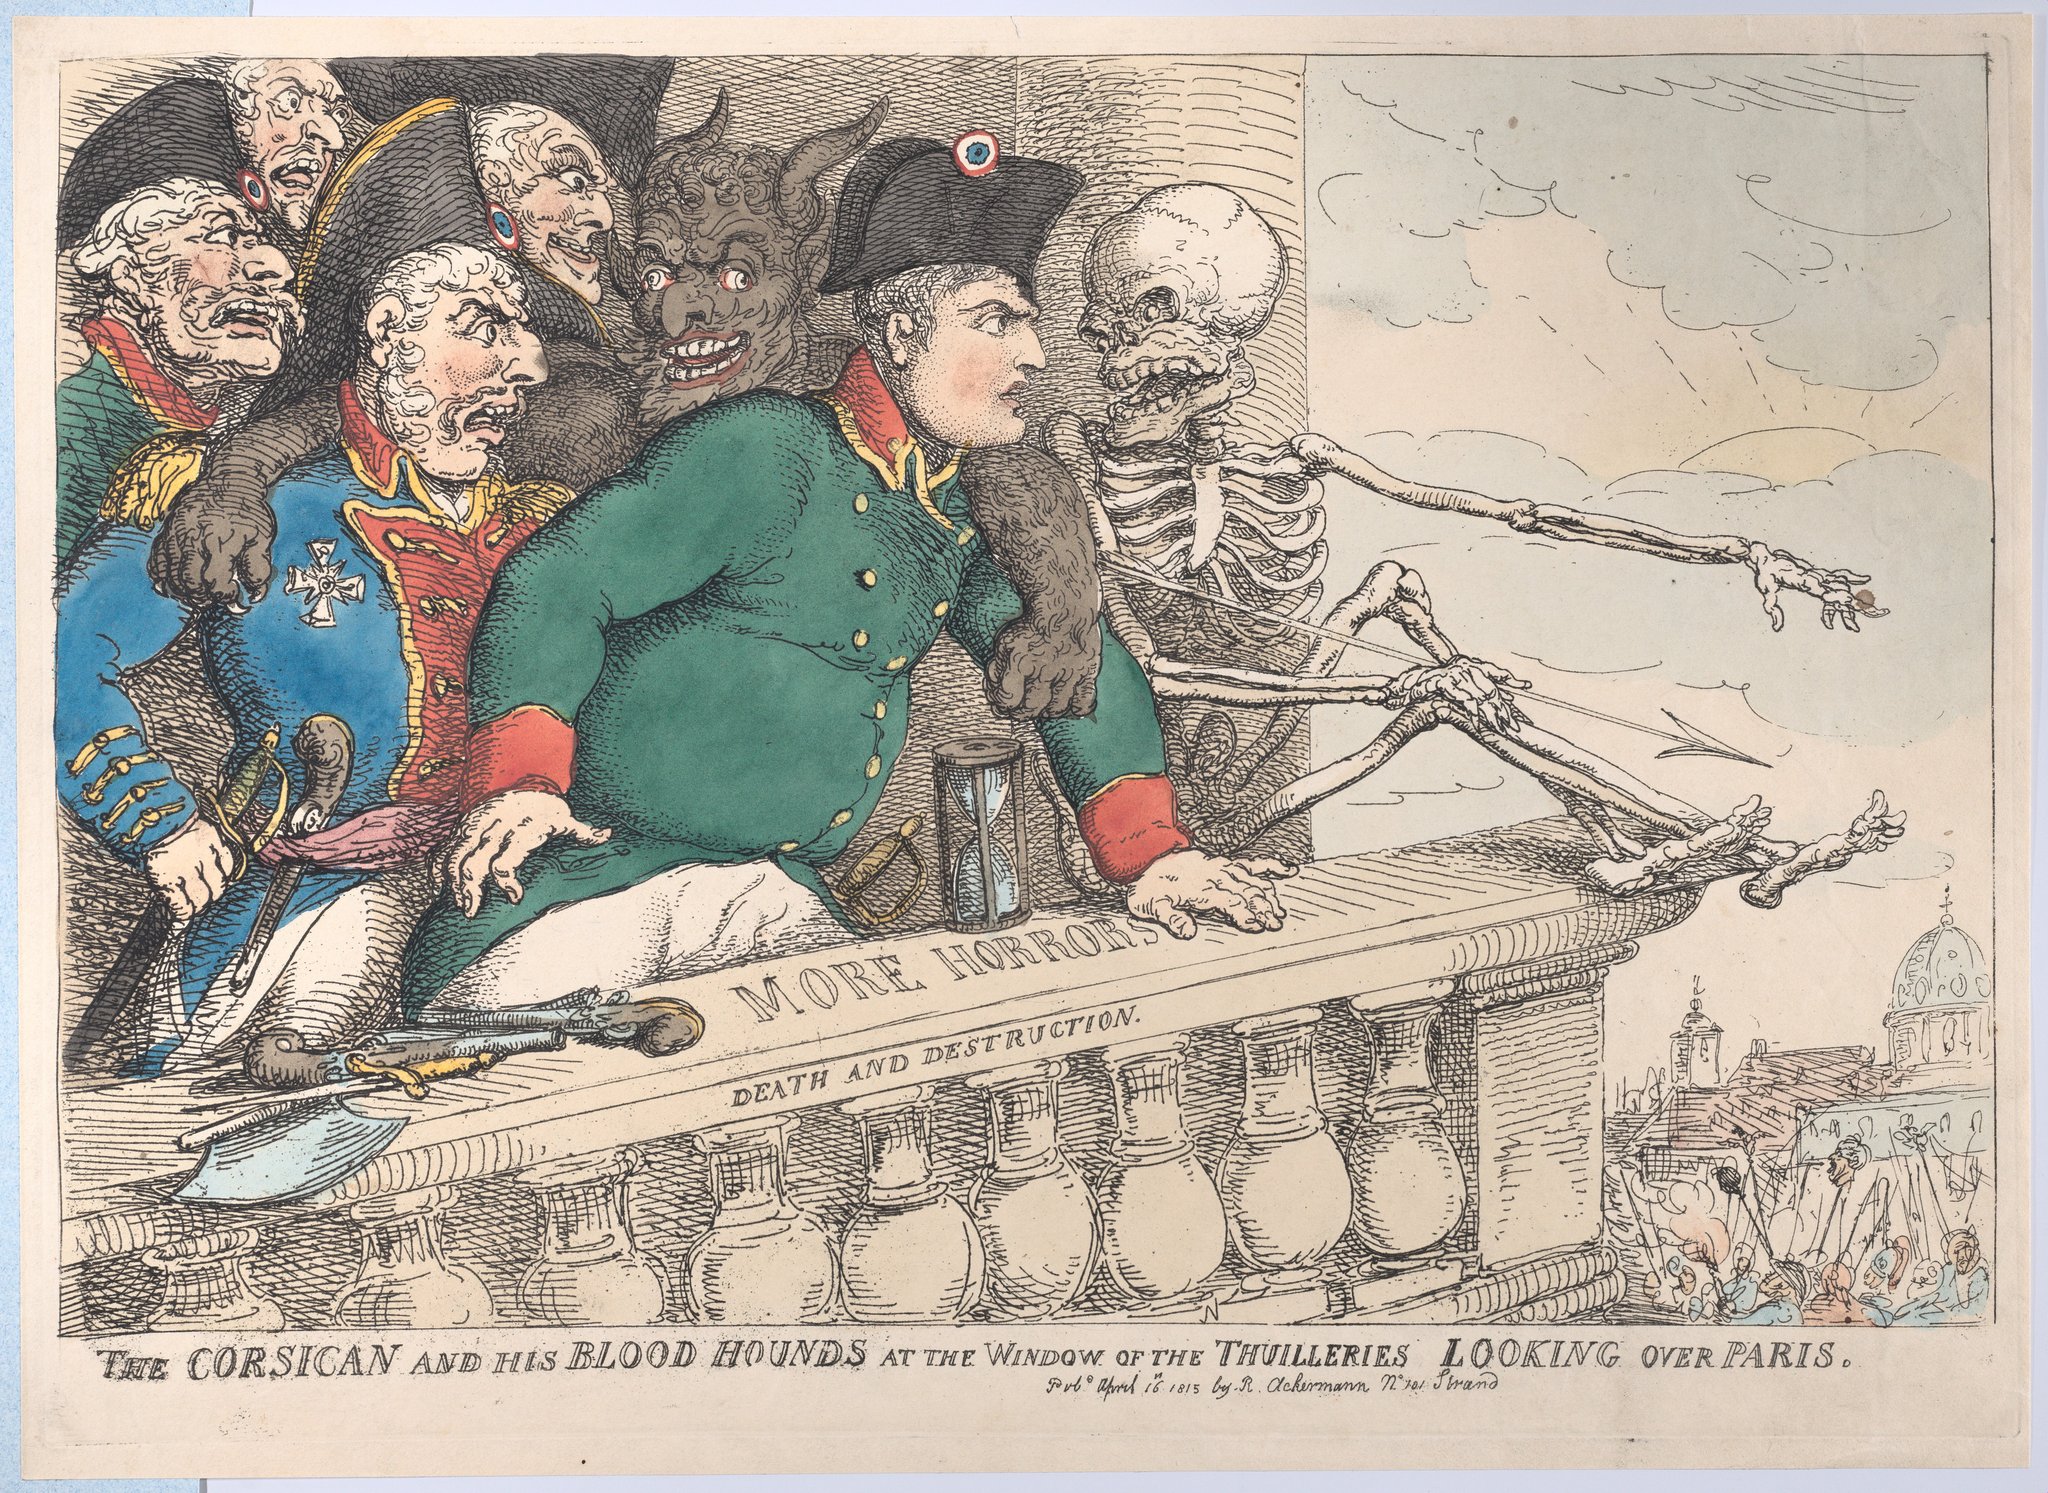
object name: print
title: The Corsican and His Bloodhounds at the Window of the Thuilleries Looking Over Paris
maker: thomas rowlandson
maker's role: artist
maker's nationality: british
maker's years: 1757-1827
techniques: etching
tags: satire,napoleon i,skeletons,men,devil,politics